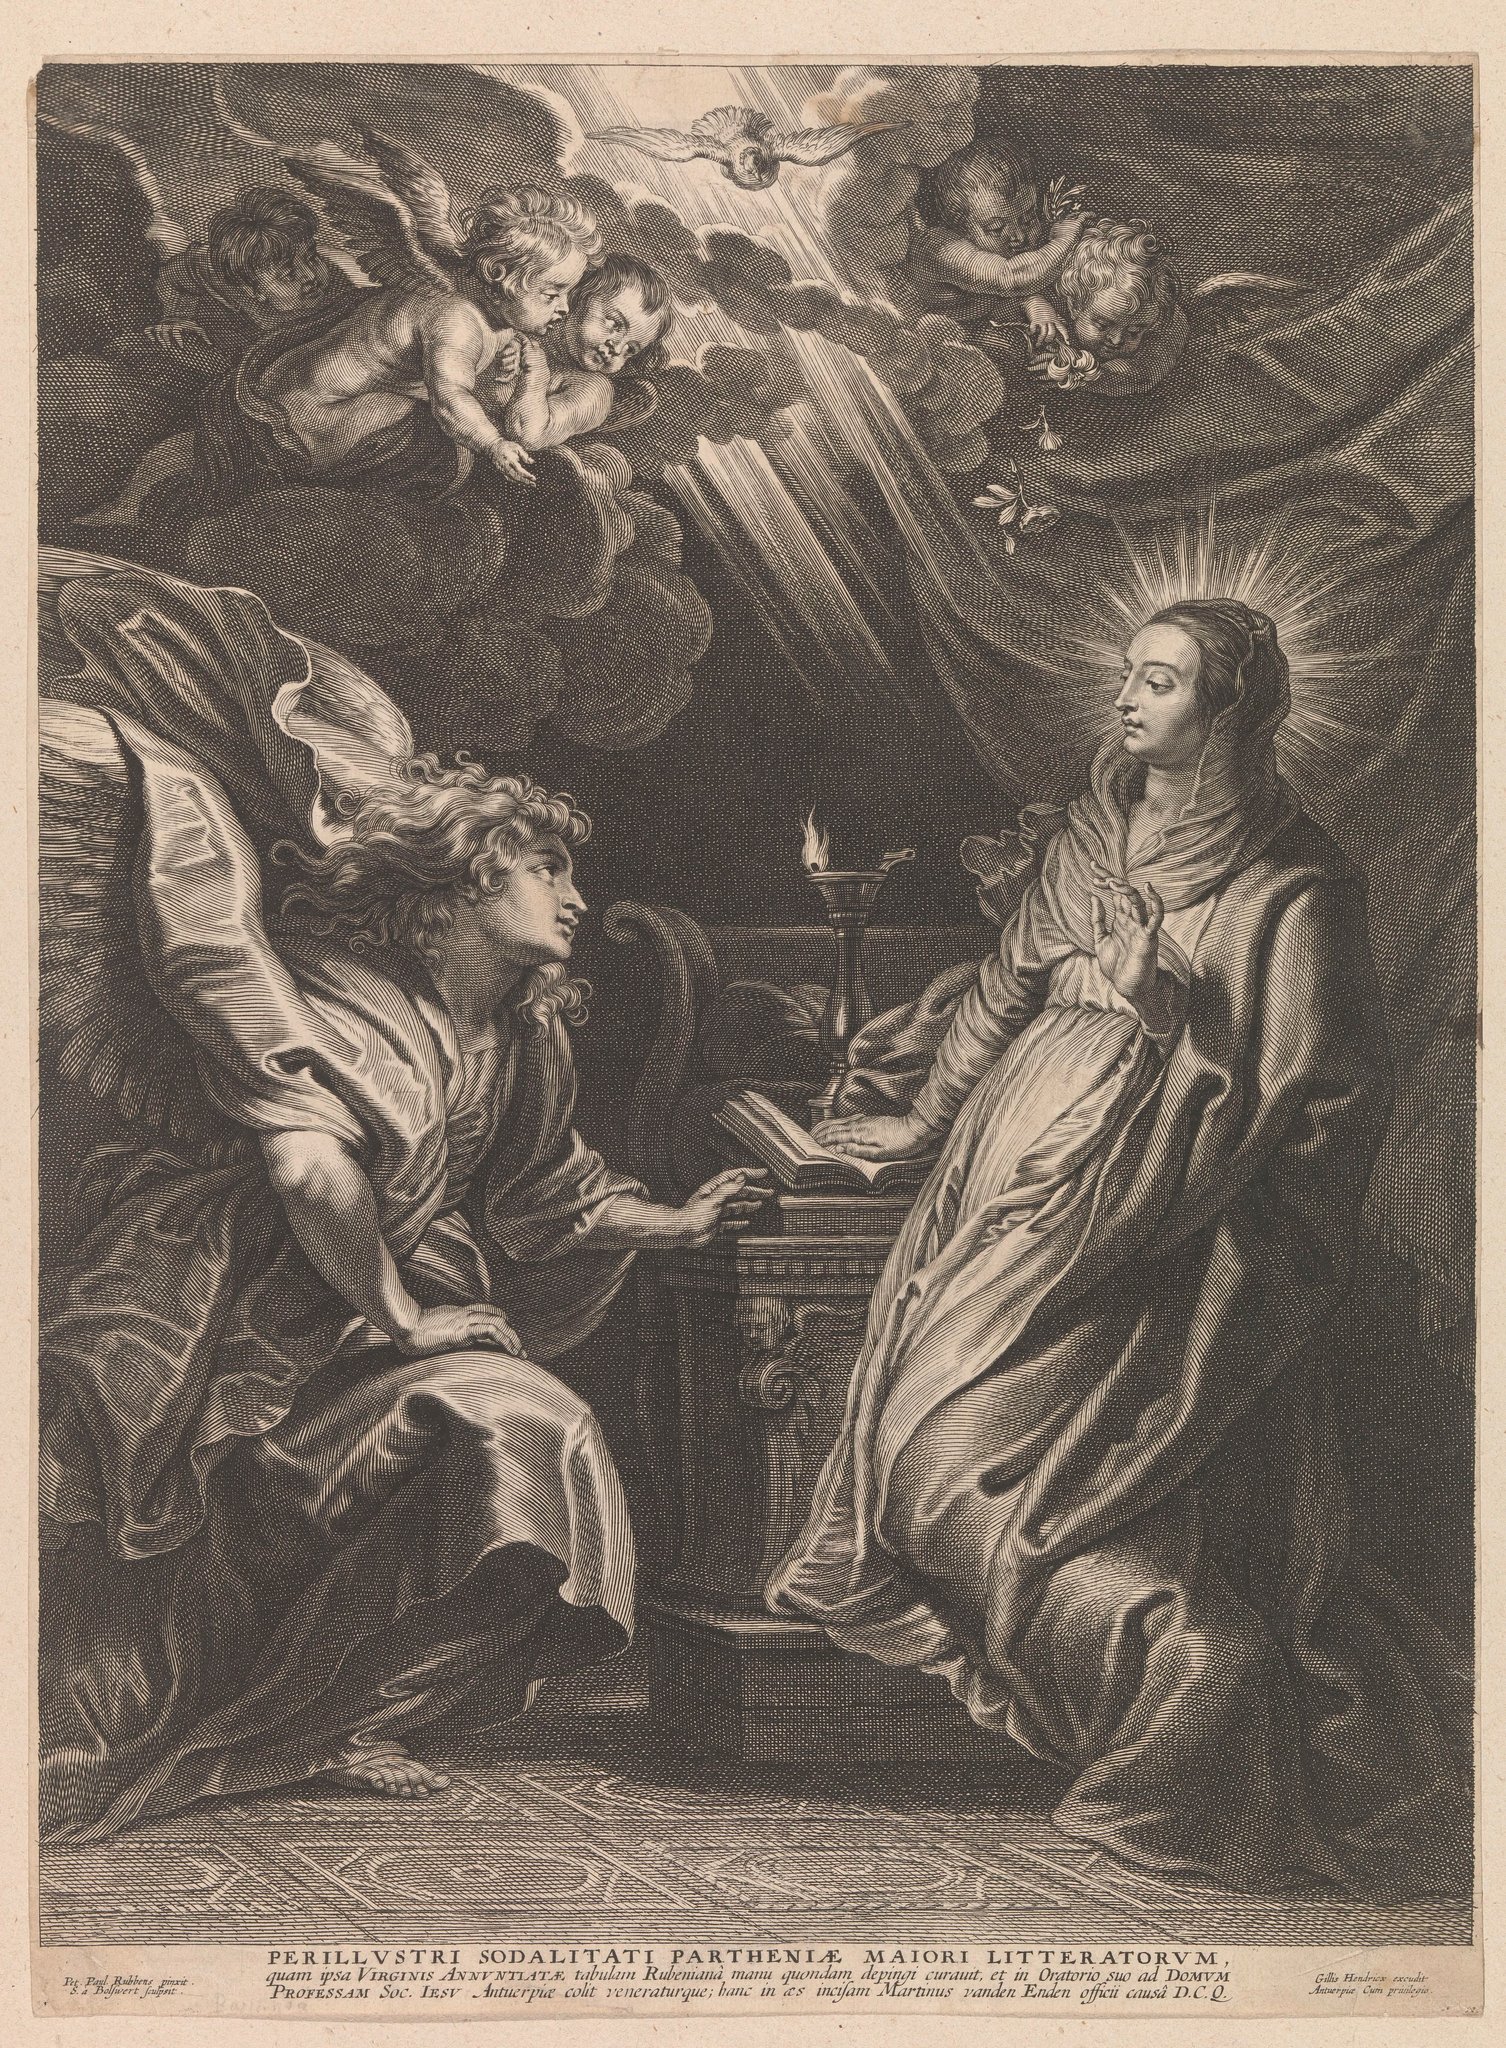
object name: print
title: Annunciatie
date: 1596-1659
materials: paper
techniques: engraving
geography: antwerp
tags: the annunciation: mary, usually reading, is visited by the angel (sometimes a woman overhears the conversation)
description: Deze prent maakt deel uit van een album.